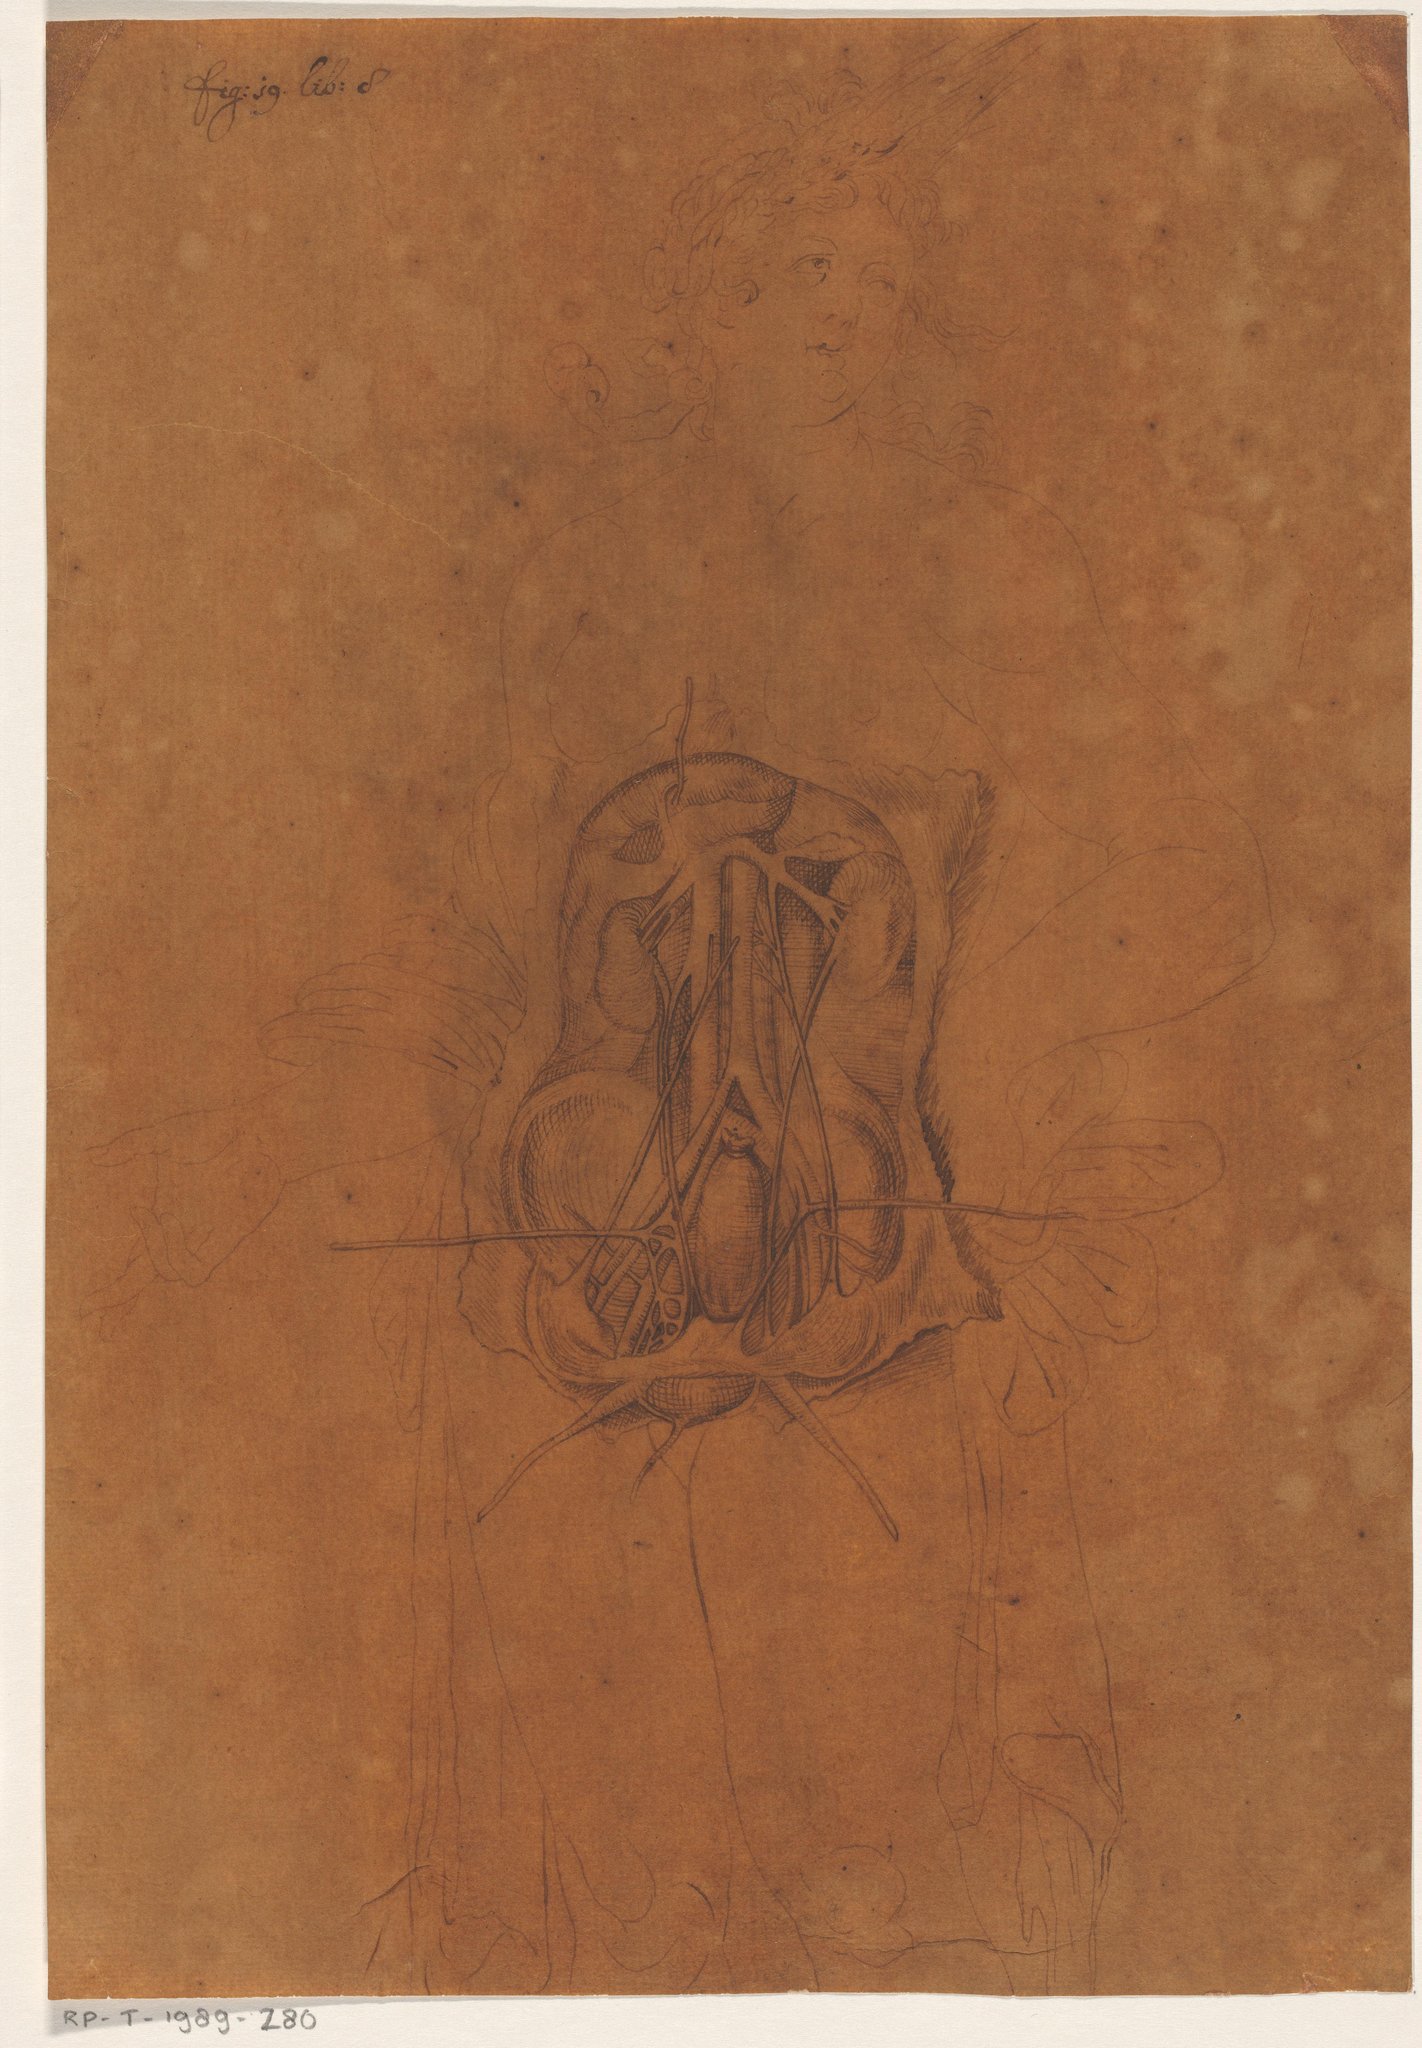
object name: drawing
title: Ingewanden van een vrouw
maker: Anonymous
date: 1630-1649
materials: ink, paper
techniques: pen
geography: low countries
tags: intestines, intestines - aa - female human figure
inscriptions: collector's mark: Lugt 2228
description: De tekening komt overeen met een prent uit: Spiegel, Adriaan van den, en Daniel Bucretius. De humani corporis fabrica libri decem. Venetië: s.n., 1627. Tekening zit in een omslag met meerdere anatomische tekeningen, genummerd RP-T-1989-256 en RP-T-1989-258 t/m RP-T-1989-289.